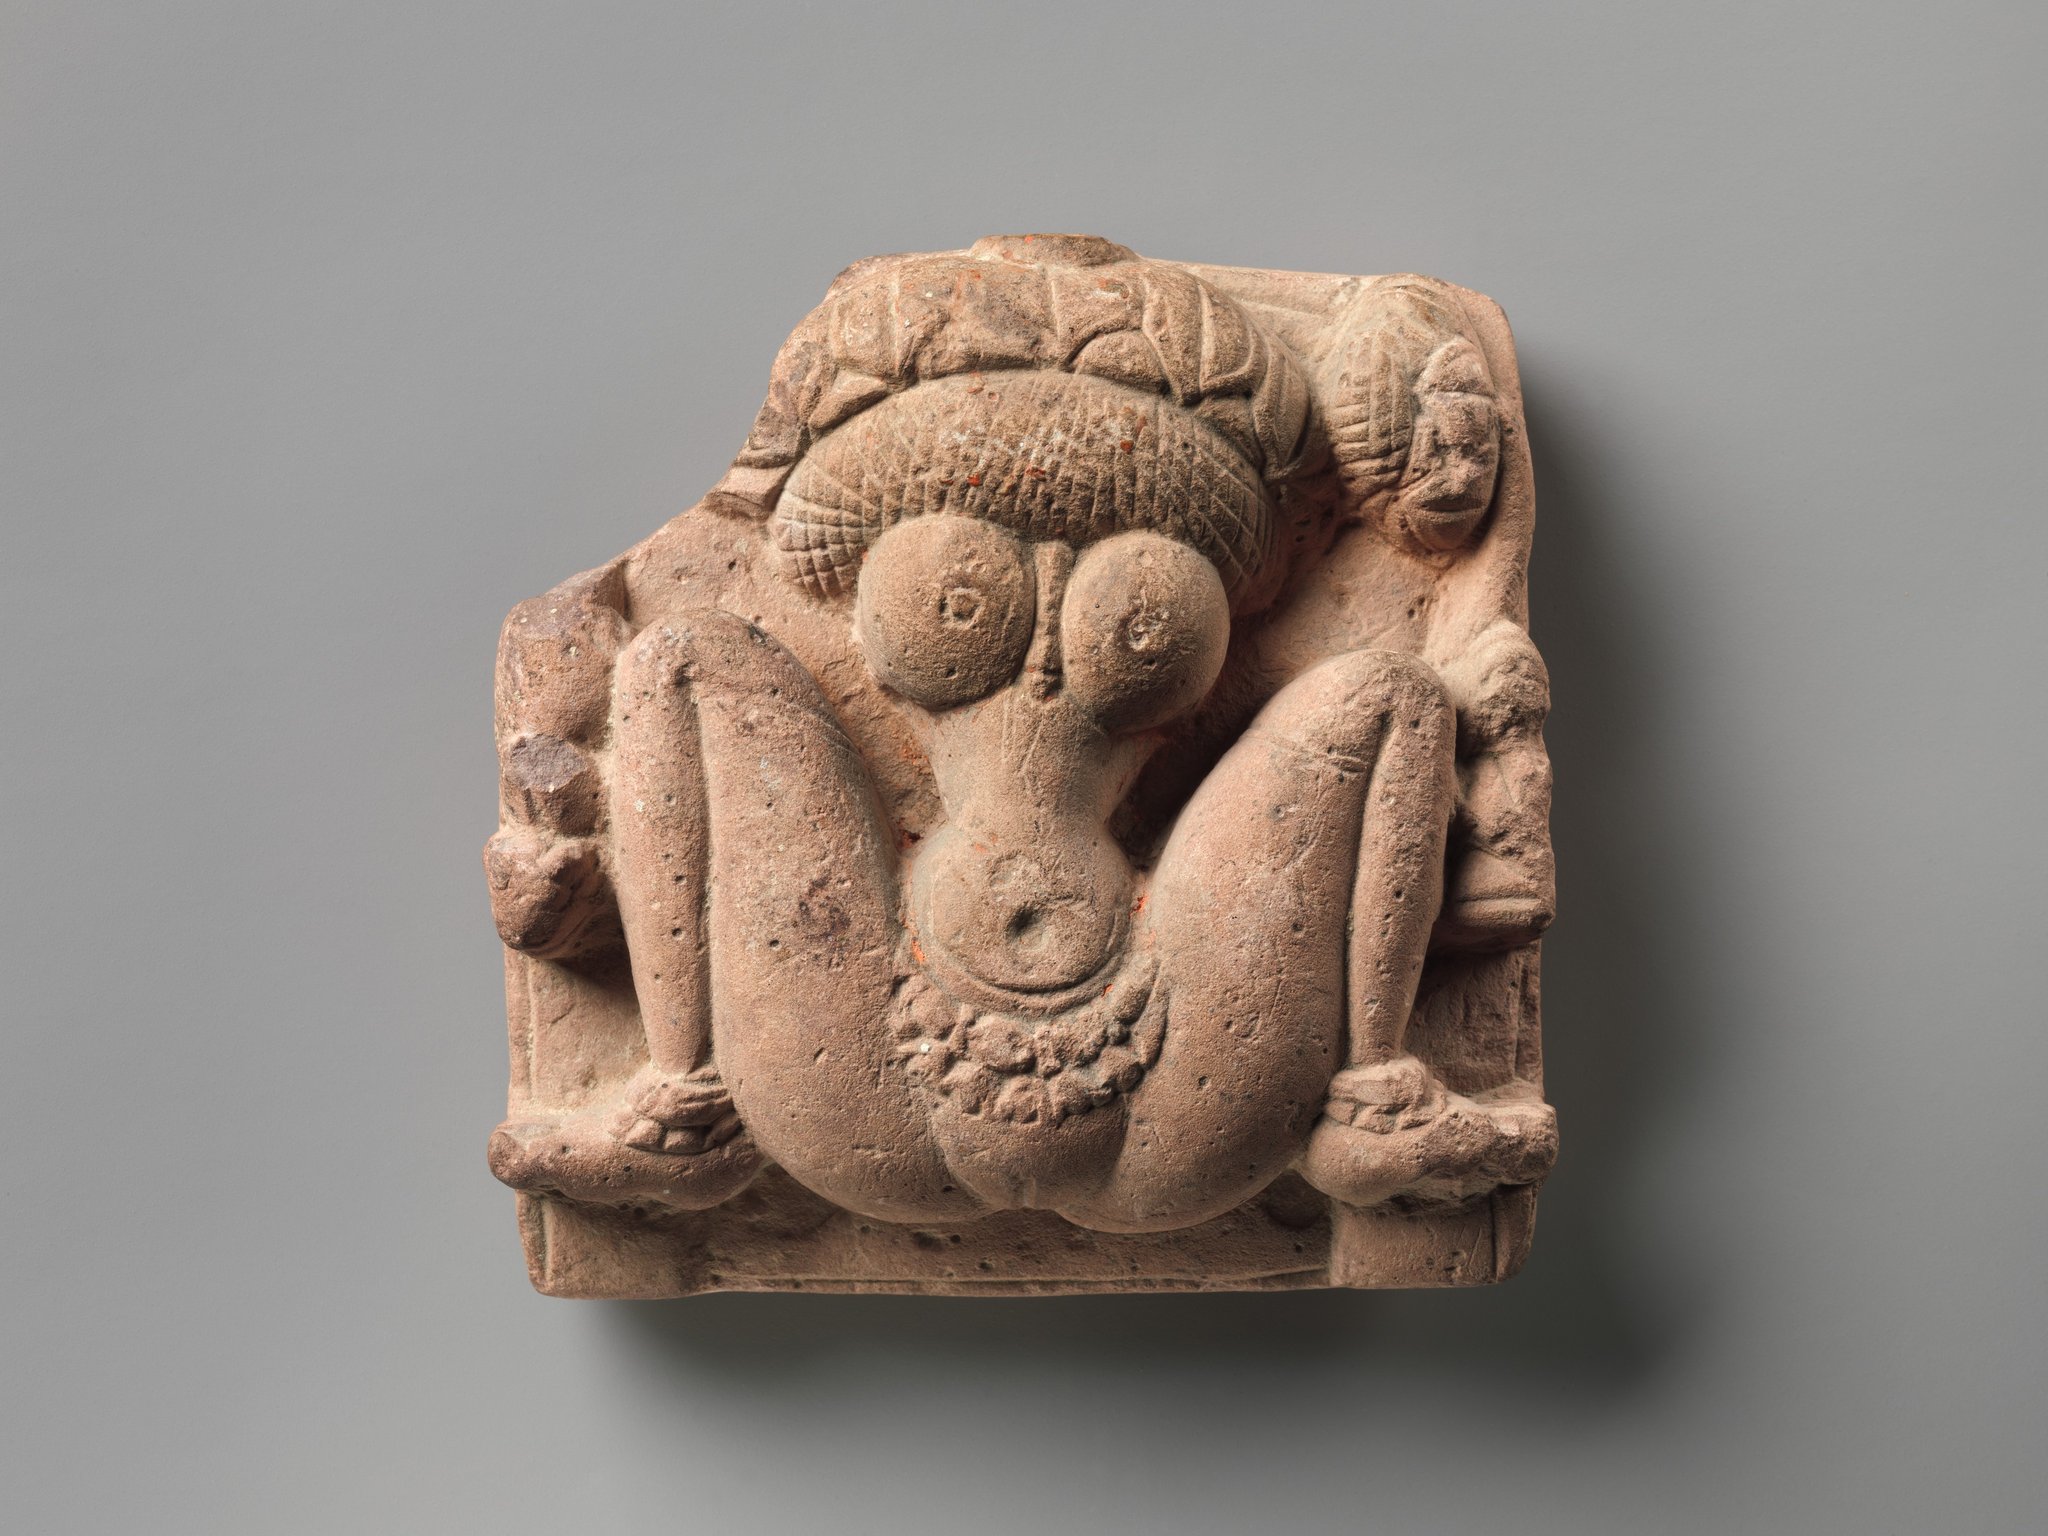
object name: relief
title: Lotus-Headed Fertility Goddess Lajja Gauri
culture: indian, madhya pradesh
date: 501-600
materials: stone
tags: post-gupta,goddess